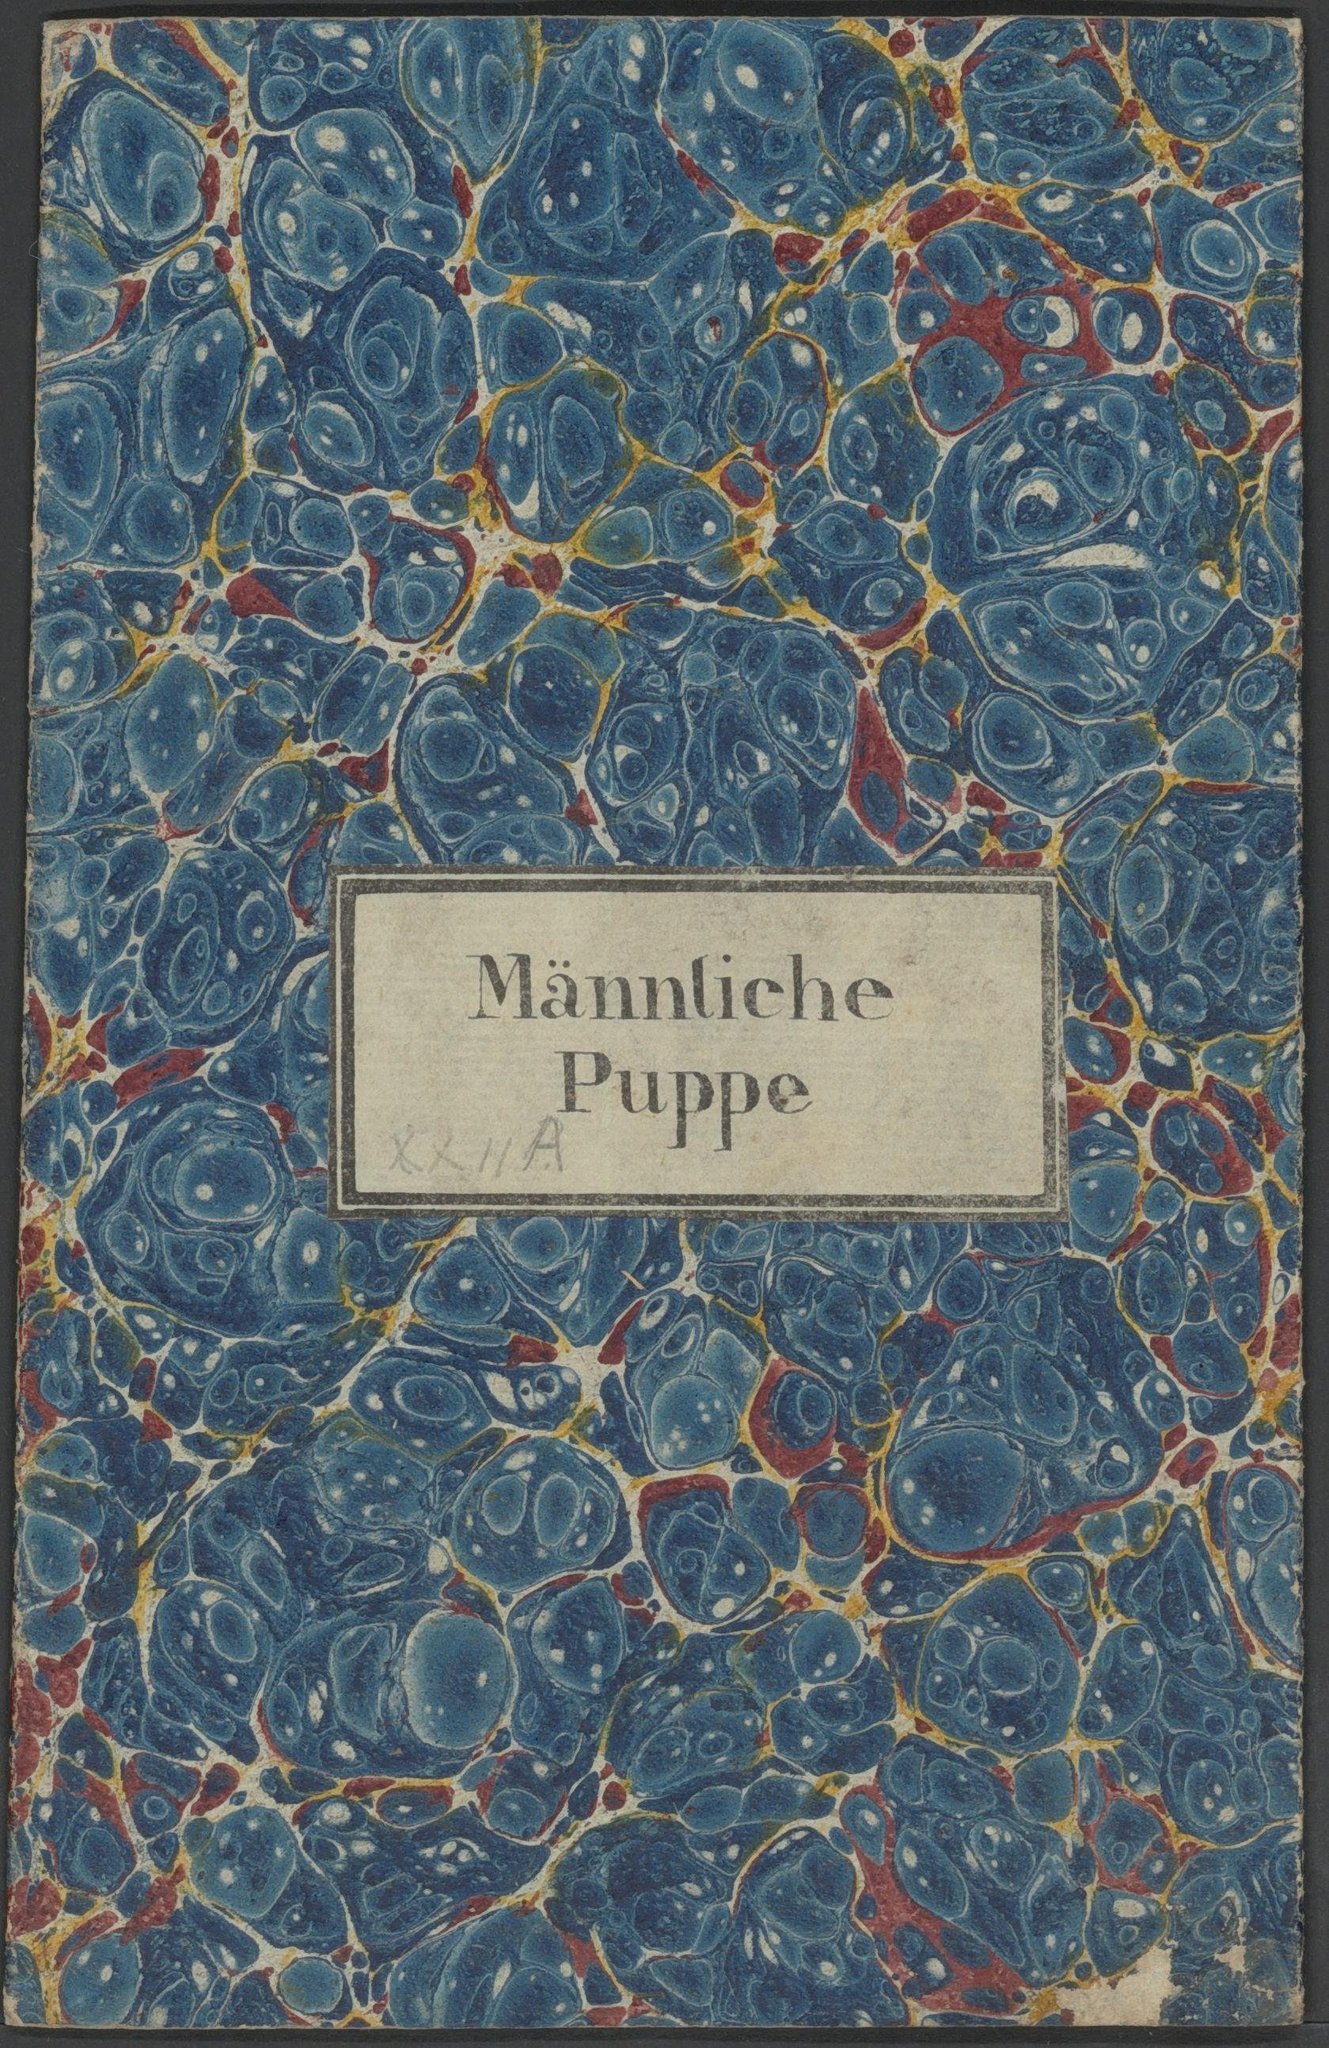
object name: folder container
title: Männliche Puppe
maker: Anonymous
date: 1875-1899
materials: paper, watercolor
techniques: etching, hand coloring, marbling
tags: fashion plates, clothes, costume (+ men's clothes)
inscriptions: collector's mark, collector's mark: Lugt 1641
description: Papieren uitvouwbare map bekleed met blauw gemarmerd papier, waarin een mannelijke aankleedpop en zes losse kostuums met benamingen in het Frans en Duits. Onderwerpsrubrieken binnen de Atlas Zeden en Gewoonten: De Kleeding, Modeplaten.